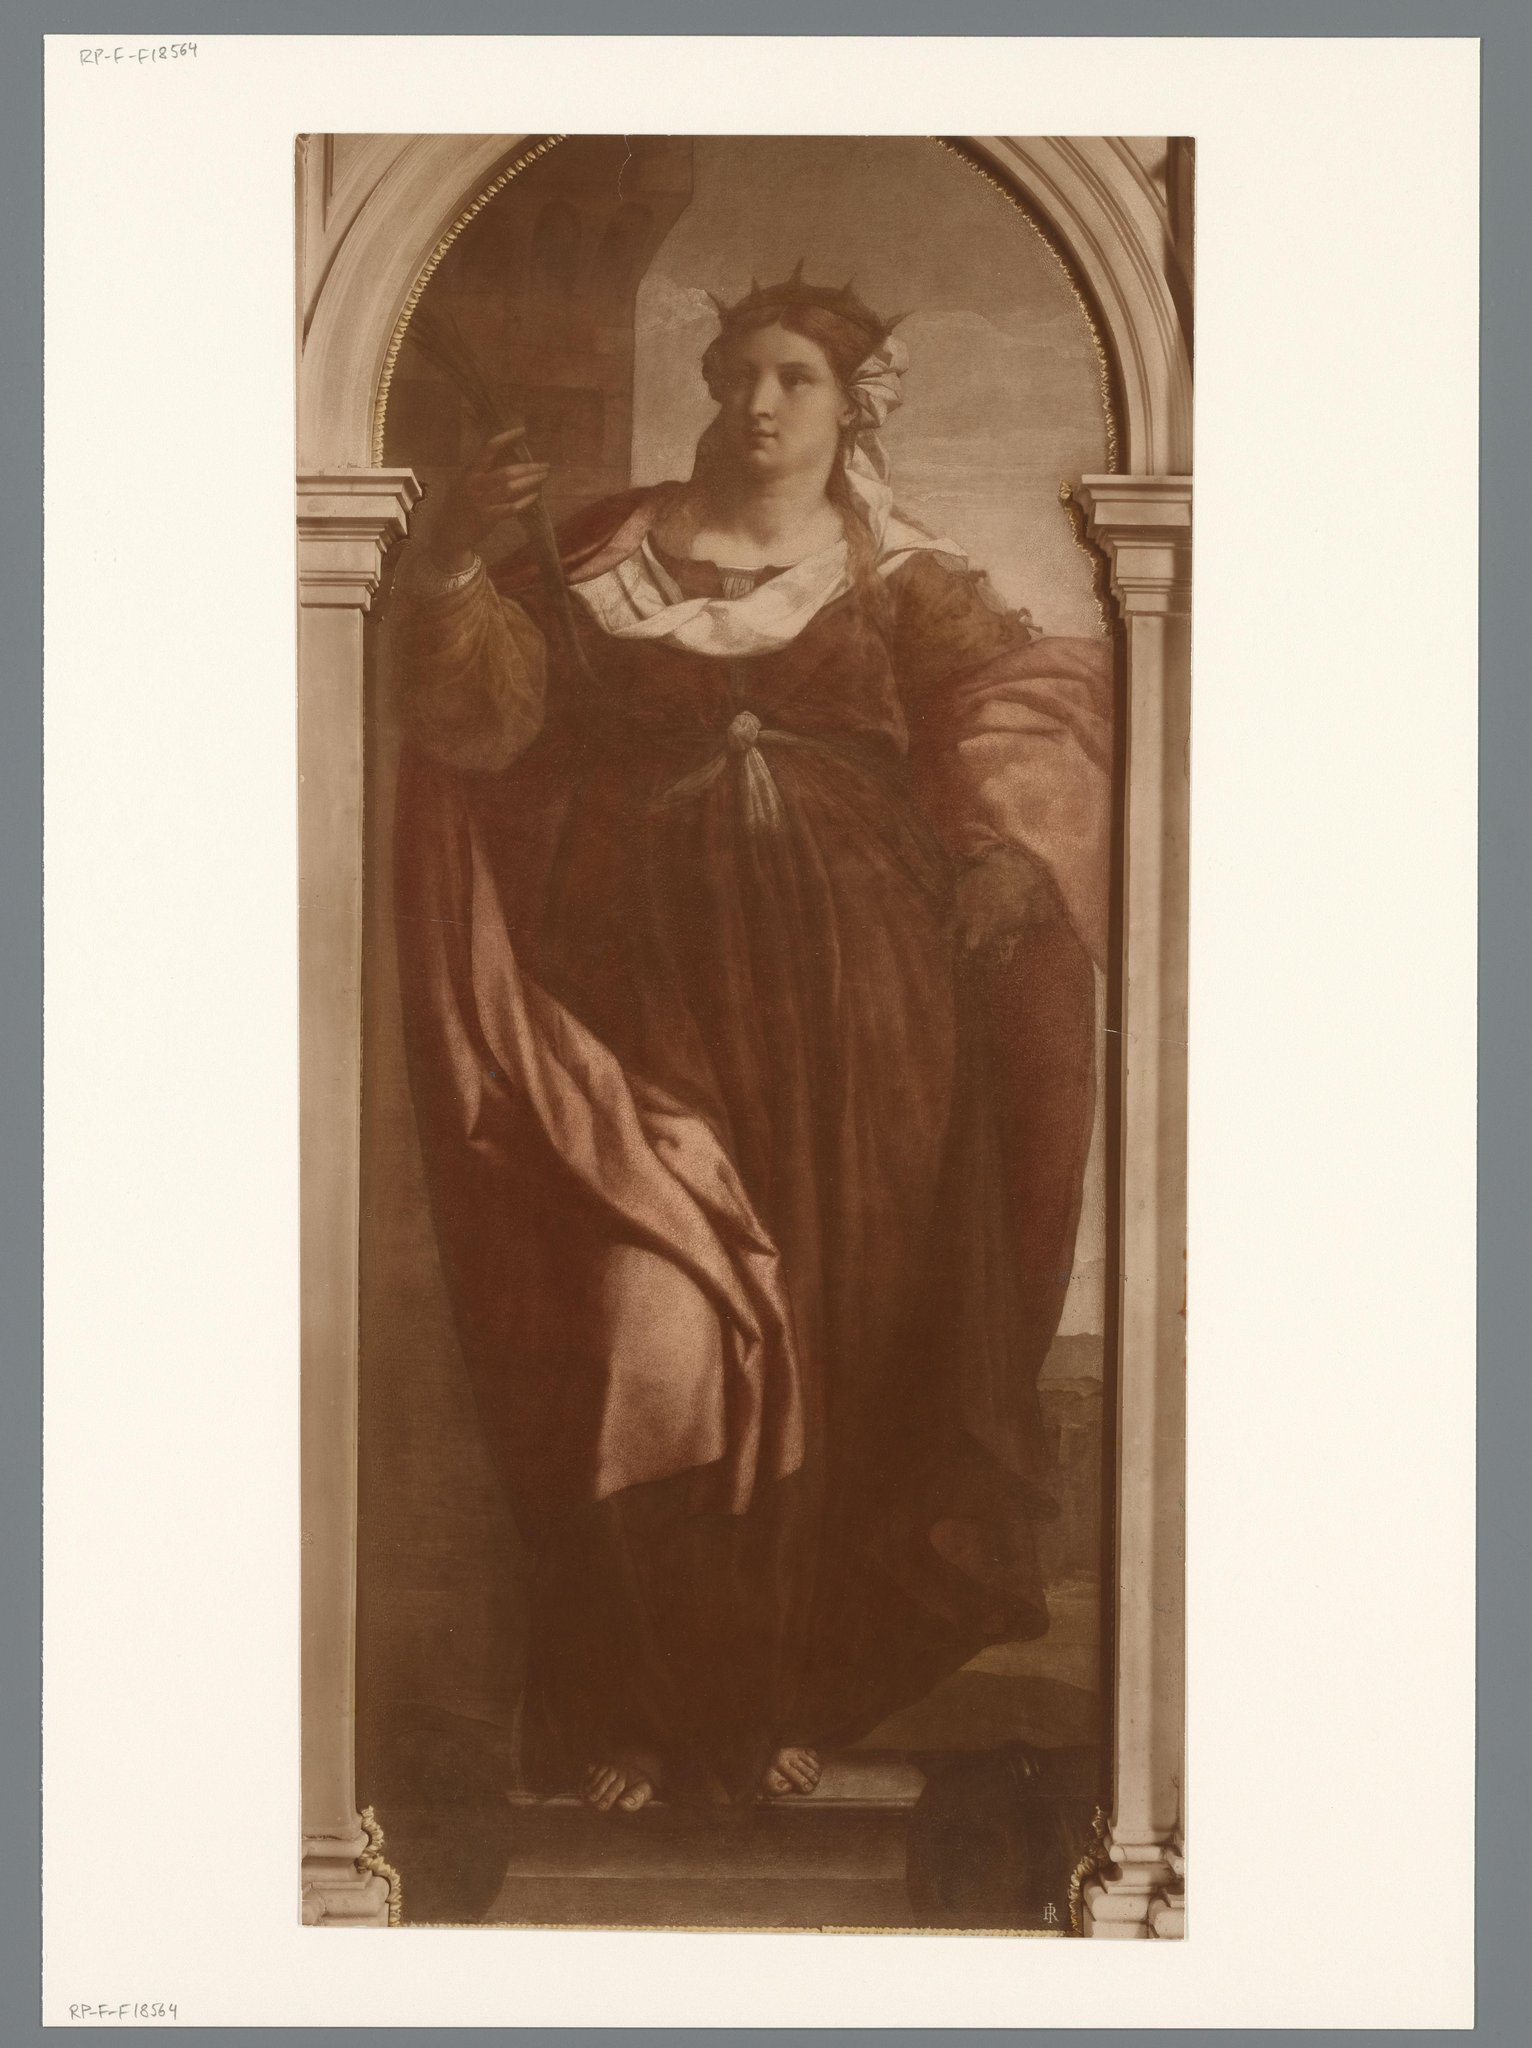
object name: reproduction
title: Fotoreproductie van een fresco van de heilige Barbara, geschilderd door Jacopo Palma in de Chiesa di Santa Maria Formosa, Venetië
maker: Anonymous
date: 1910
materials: paper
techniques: color carbon print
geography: venice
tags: the virgin martyr barbara; possible attributes: book, cannon(ball), crown, cross, chalice with wafer, dioscuros (her father), peacock feather, sword, torches, mason's tools, tower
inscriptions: inscription: ‘1187J Venezia S. Barbara Palma il Vecchio’, monogram: ‘IR’, check stamp: ‘Brogi/ [...]nze’